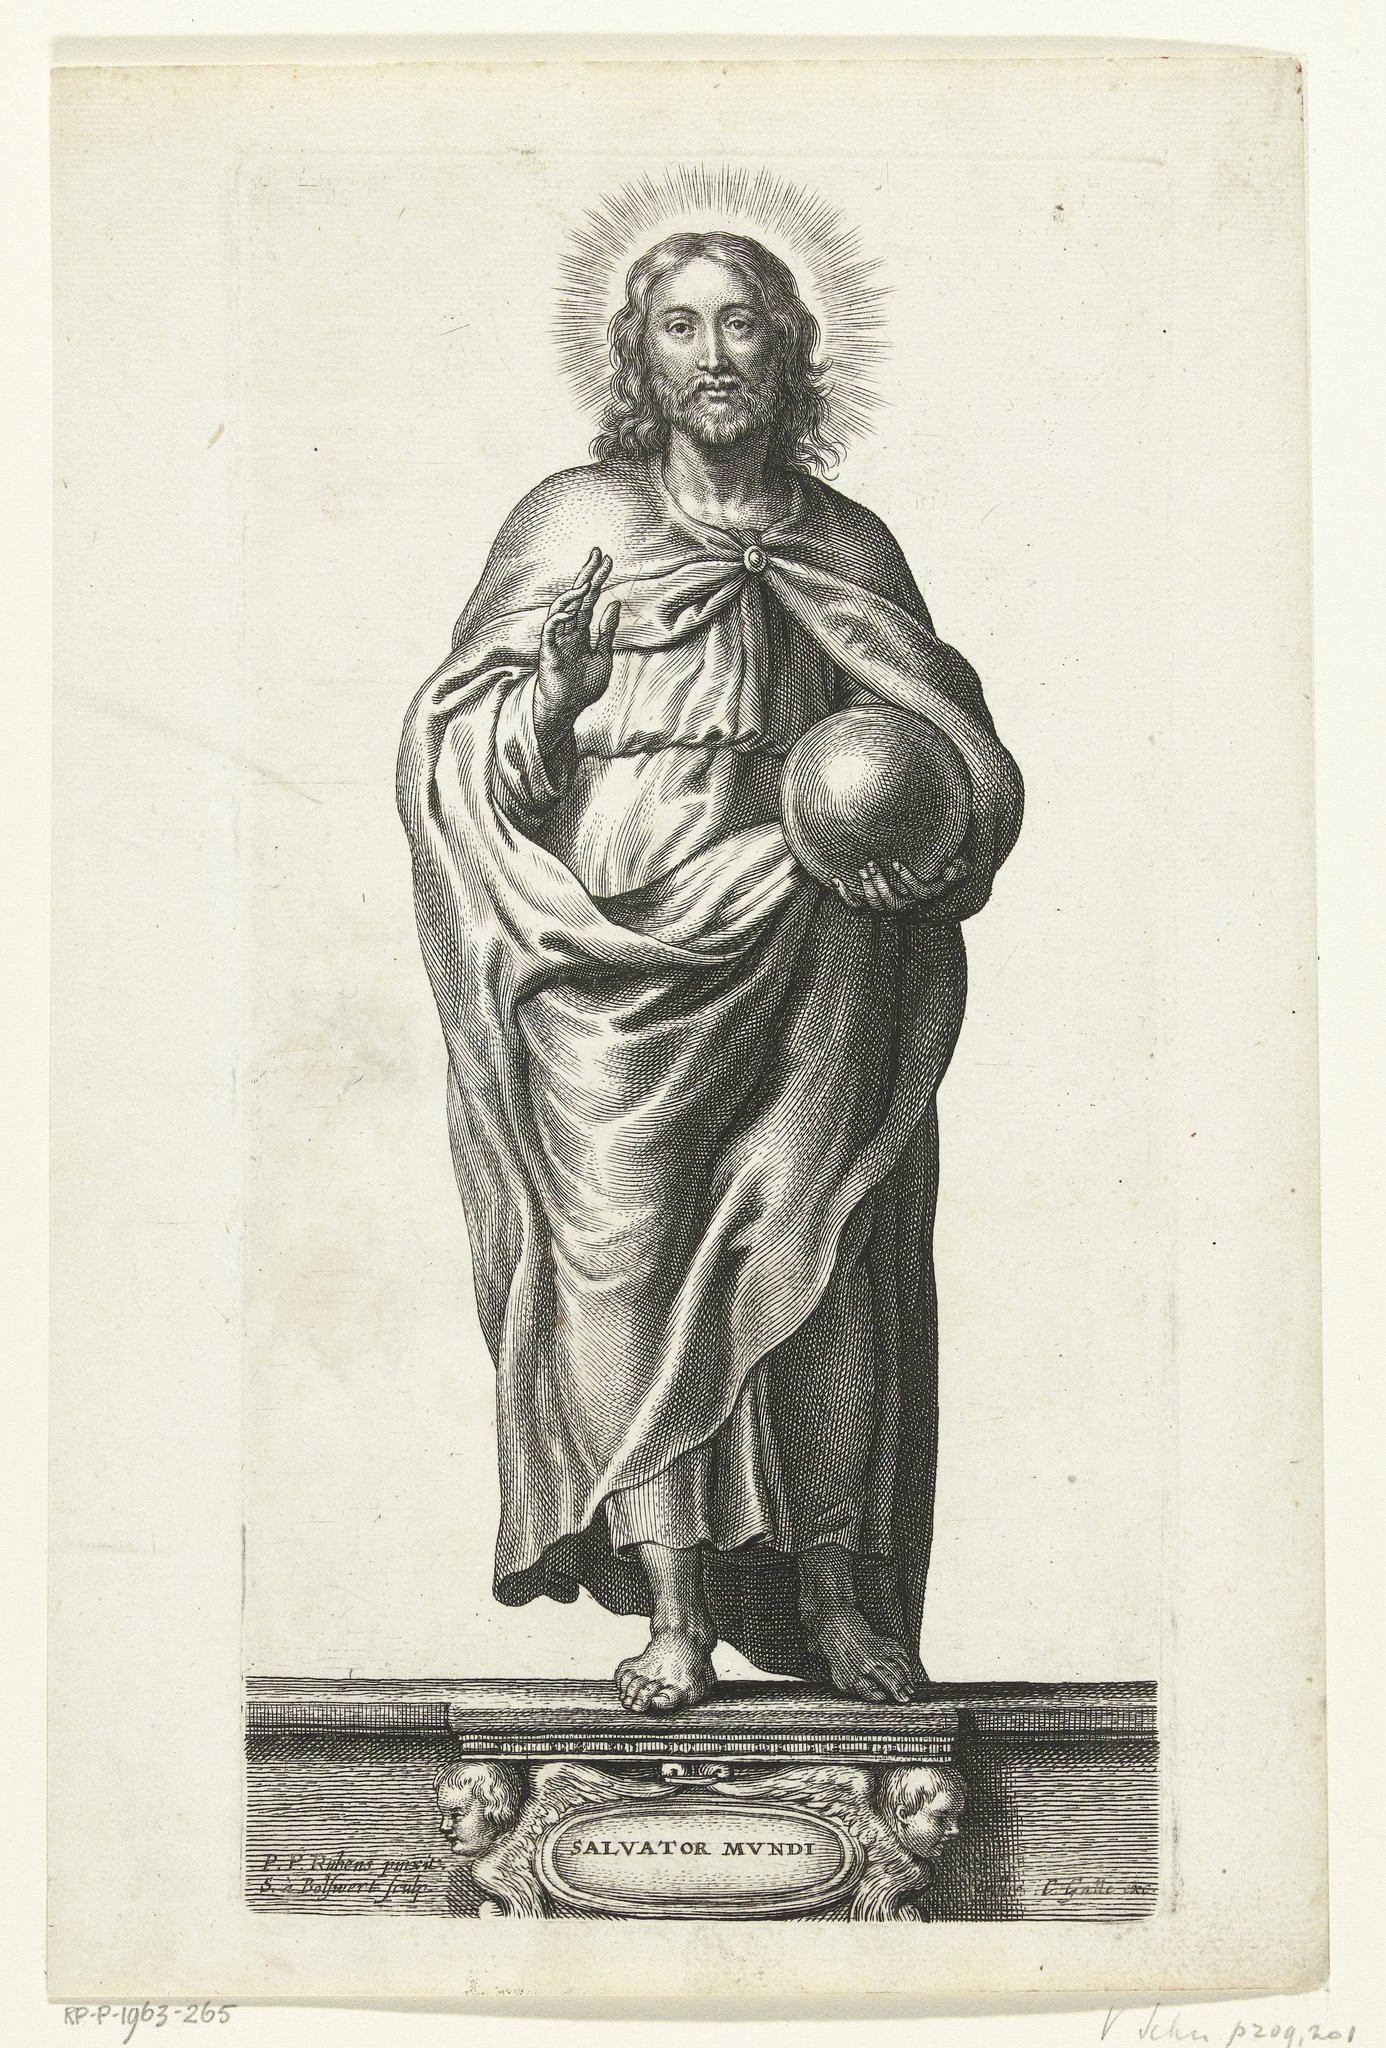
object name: print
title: Christus als Salvator Mundi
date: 1596-1659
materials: paper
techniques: engraving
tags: 'salvator mundi', making a blessing gesture; an orb in his hand or at his feet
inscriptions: collector's mark: Lugt 2760, collector's mark: Lugt 2228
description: Prent uit serie van vijftien prenten naar ontwerp van Peter Paul Rubens met de serietitel SS. Apostolorum Icones.